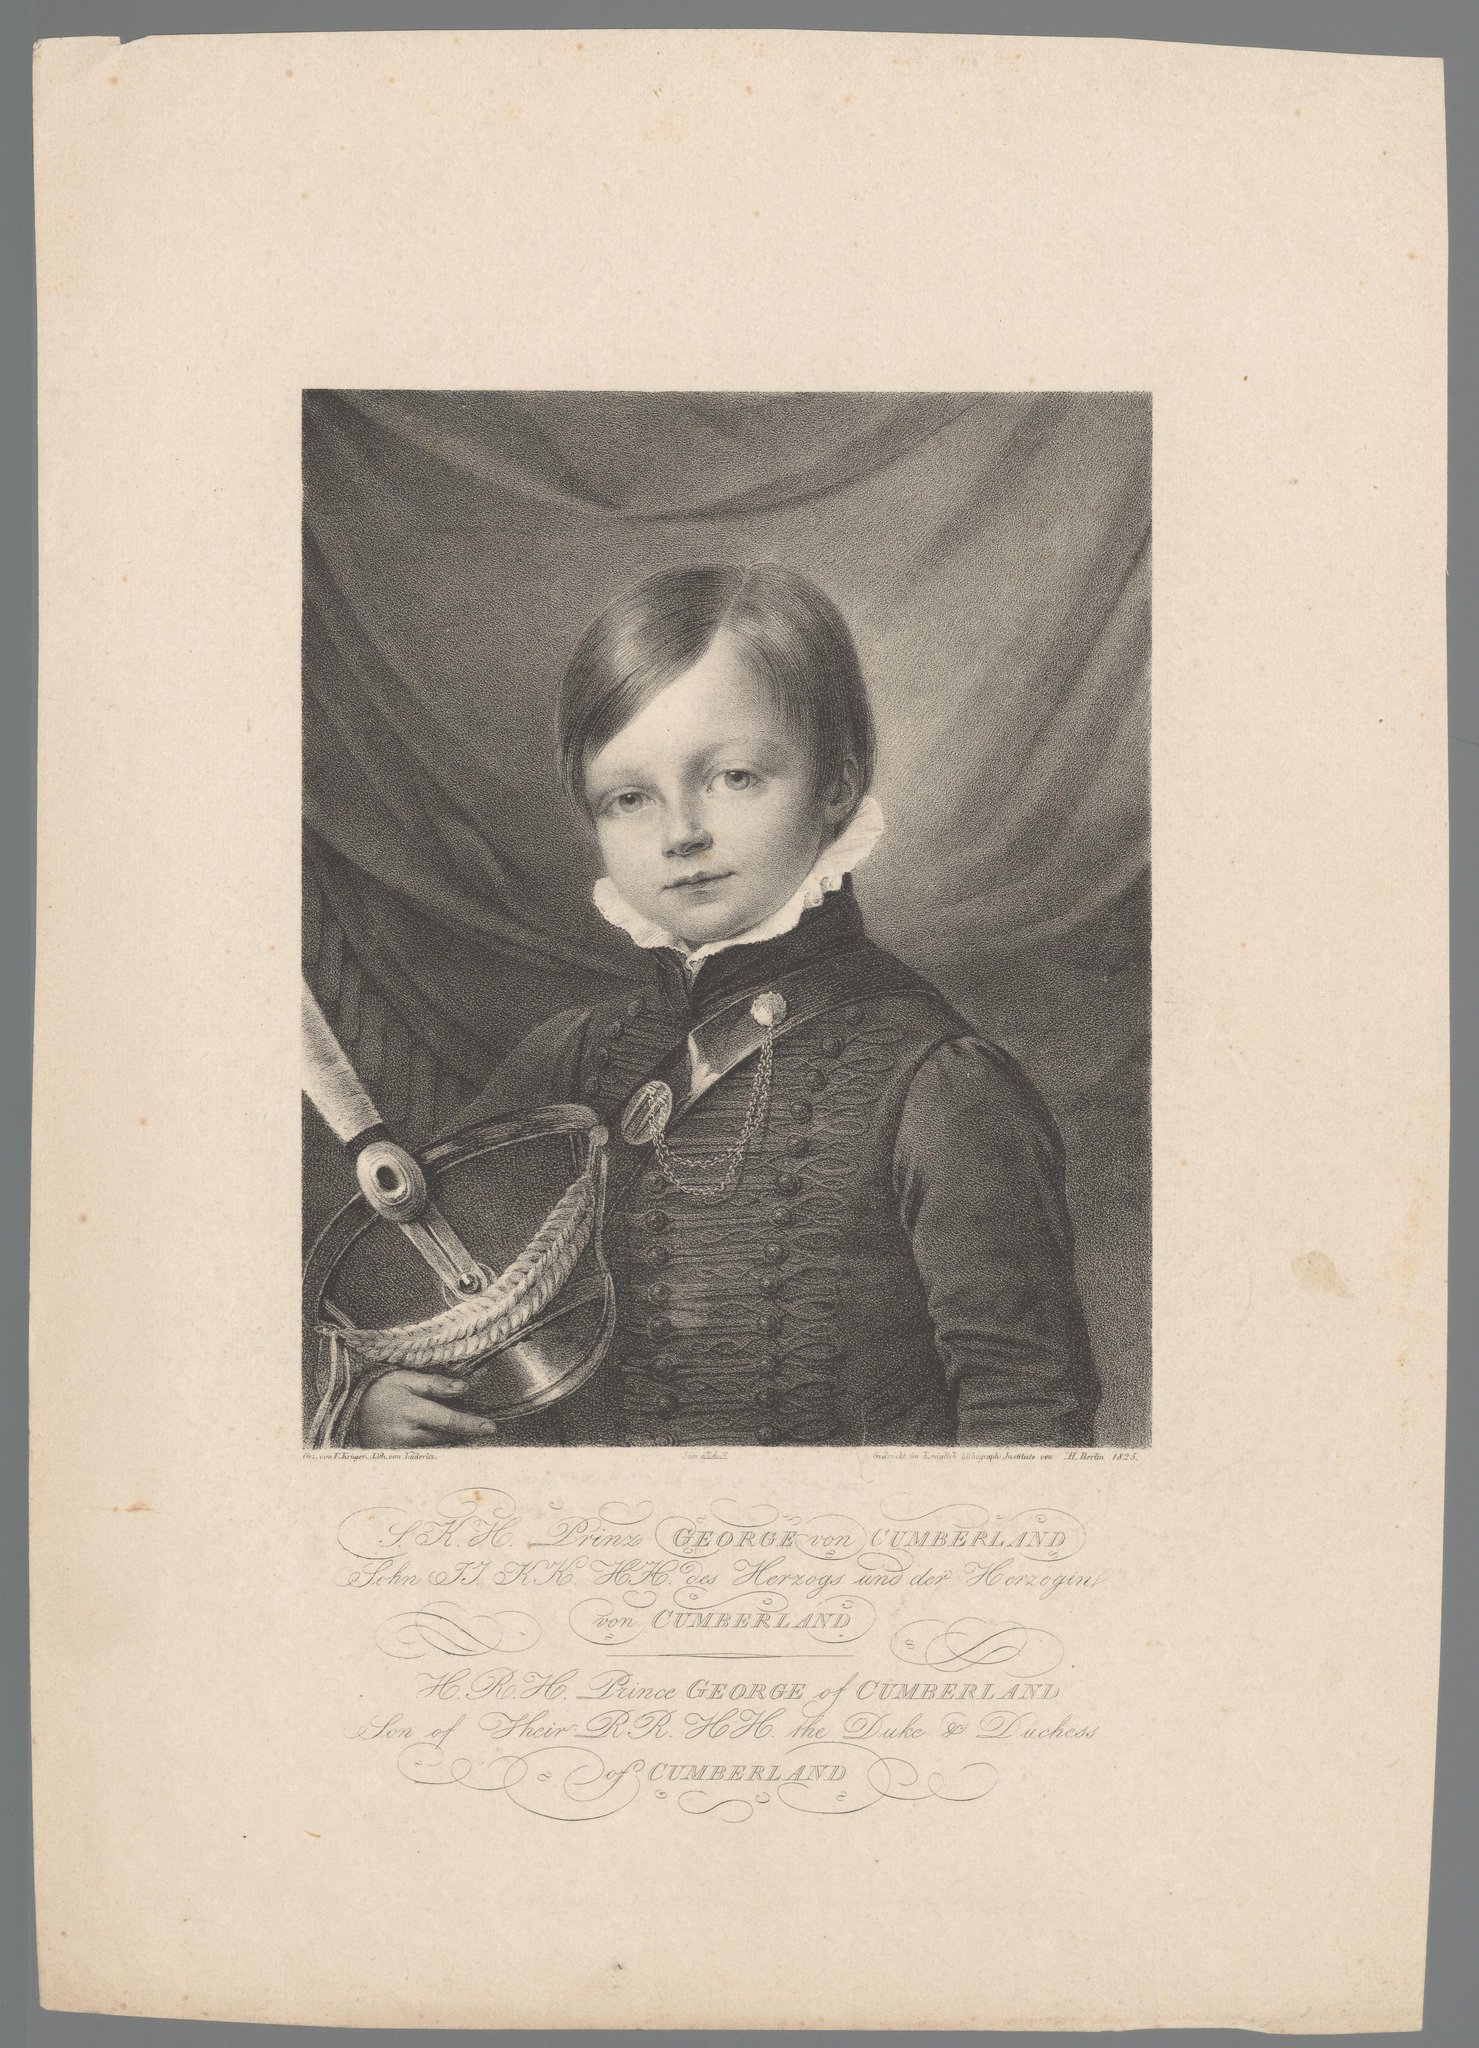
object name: print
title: S.K.H. Prinz George von Cumberland (...)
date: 1825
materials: paper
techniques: lithograph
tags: prince, historical persons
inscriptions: collector's mark: Lugt 2228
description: Portret van George V, koning van Hannover, als kind.